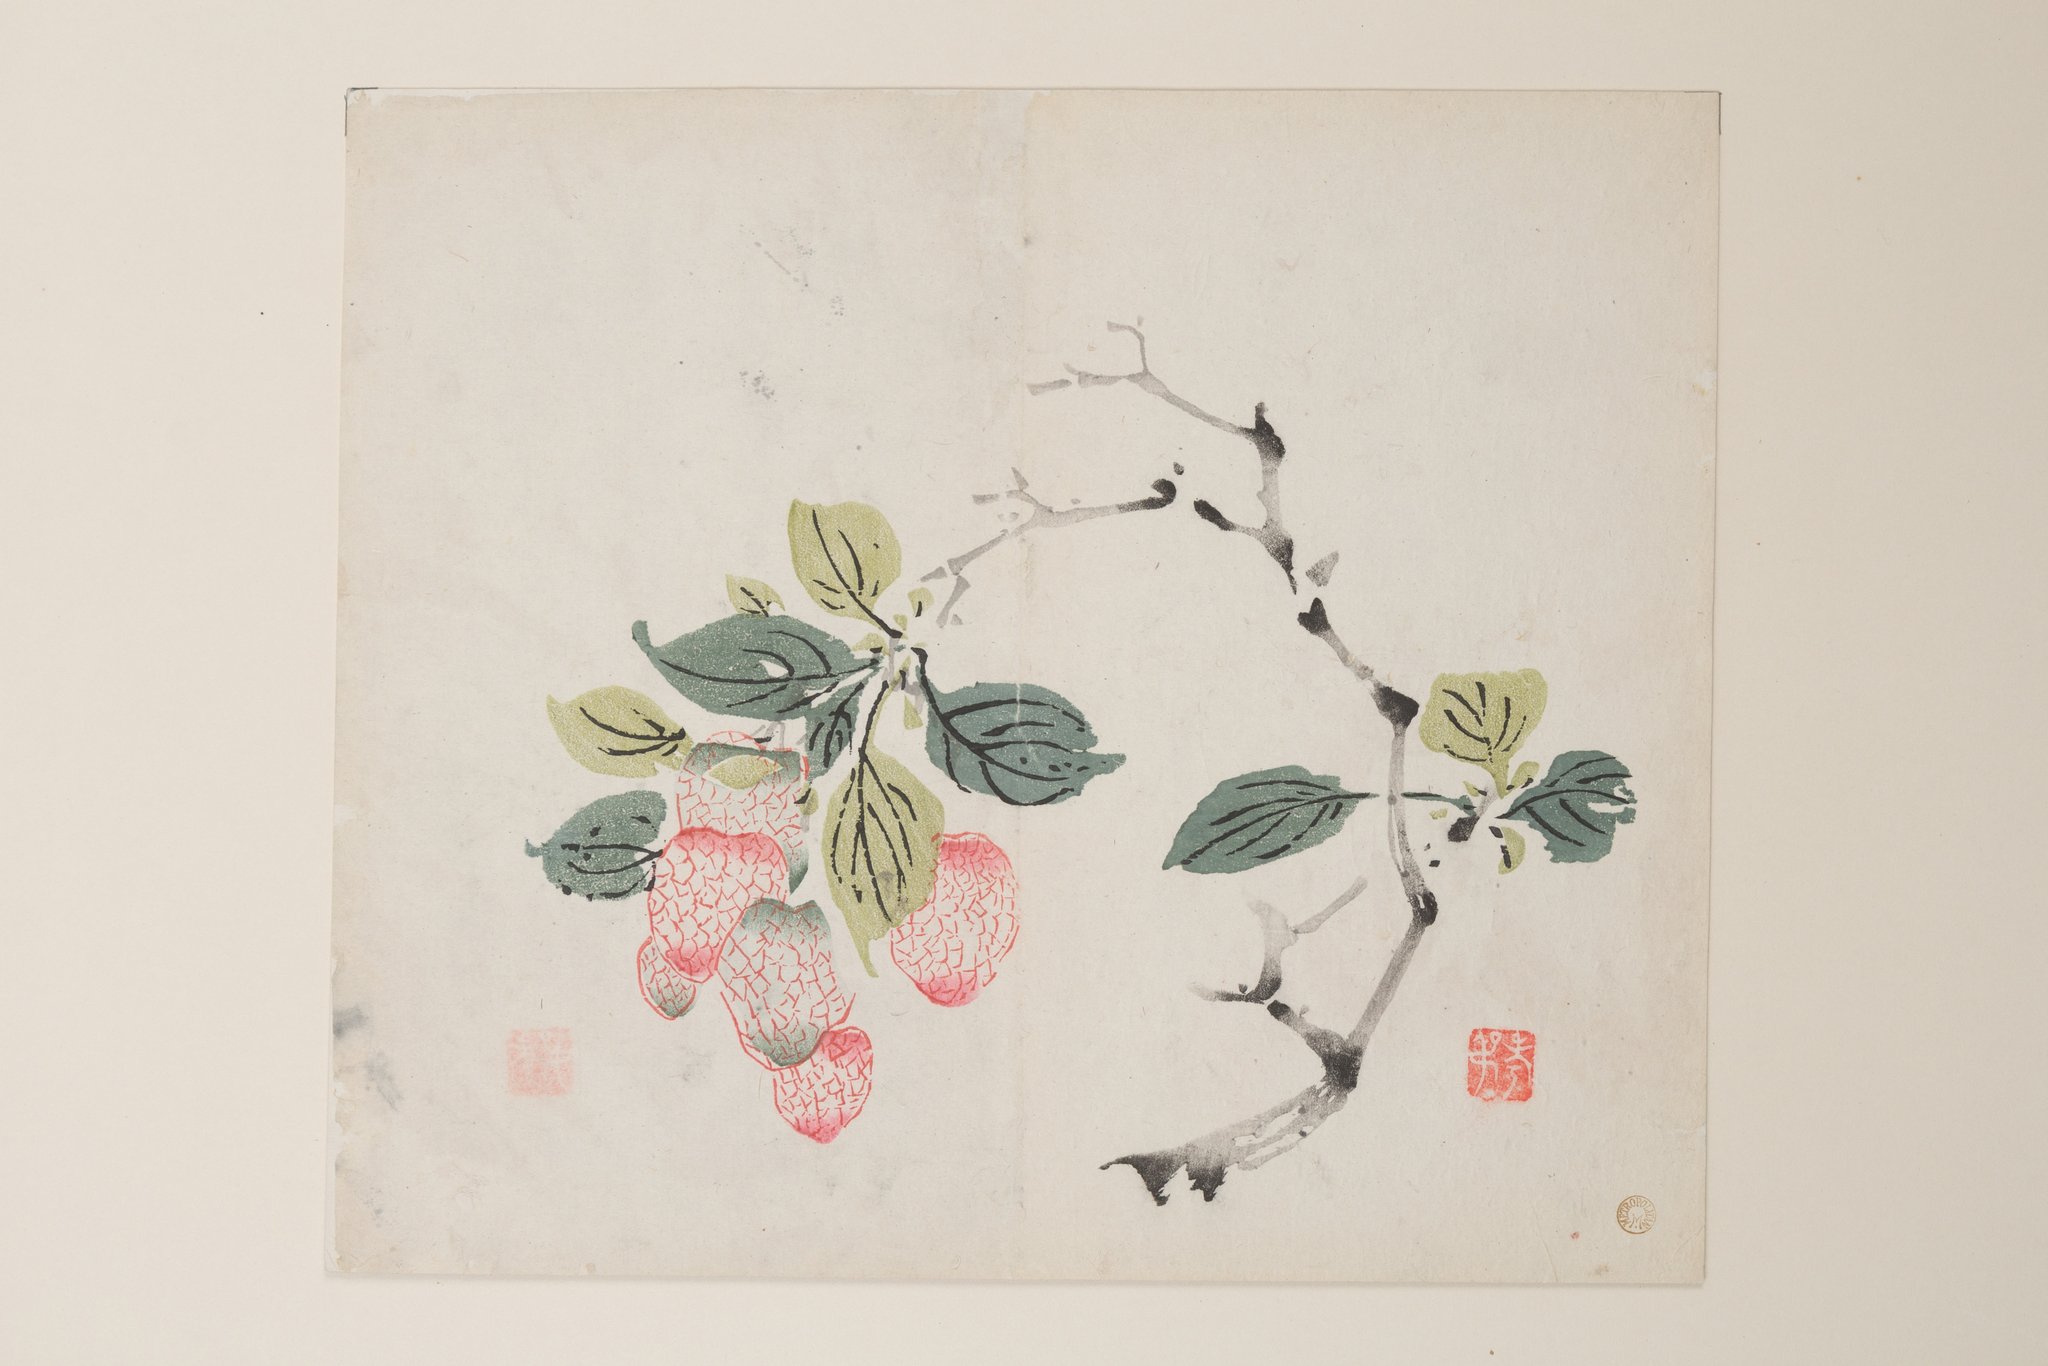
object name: print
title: Leaf from the Ten Bamboo Studio Manual of Painting and Calligraphy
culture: chinese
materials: ink, paper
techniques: printing